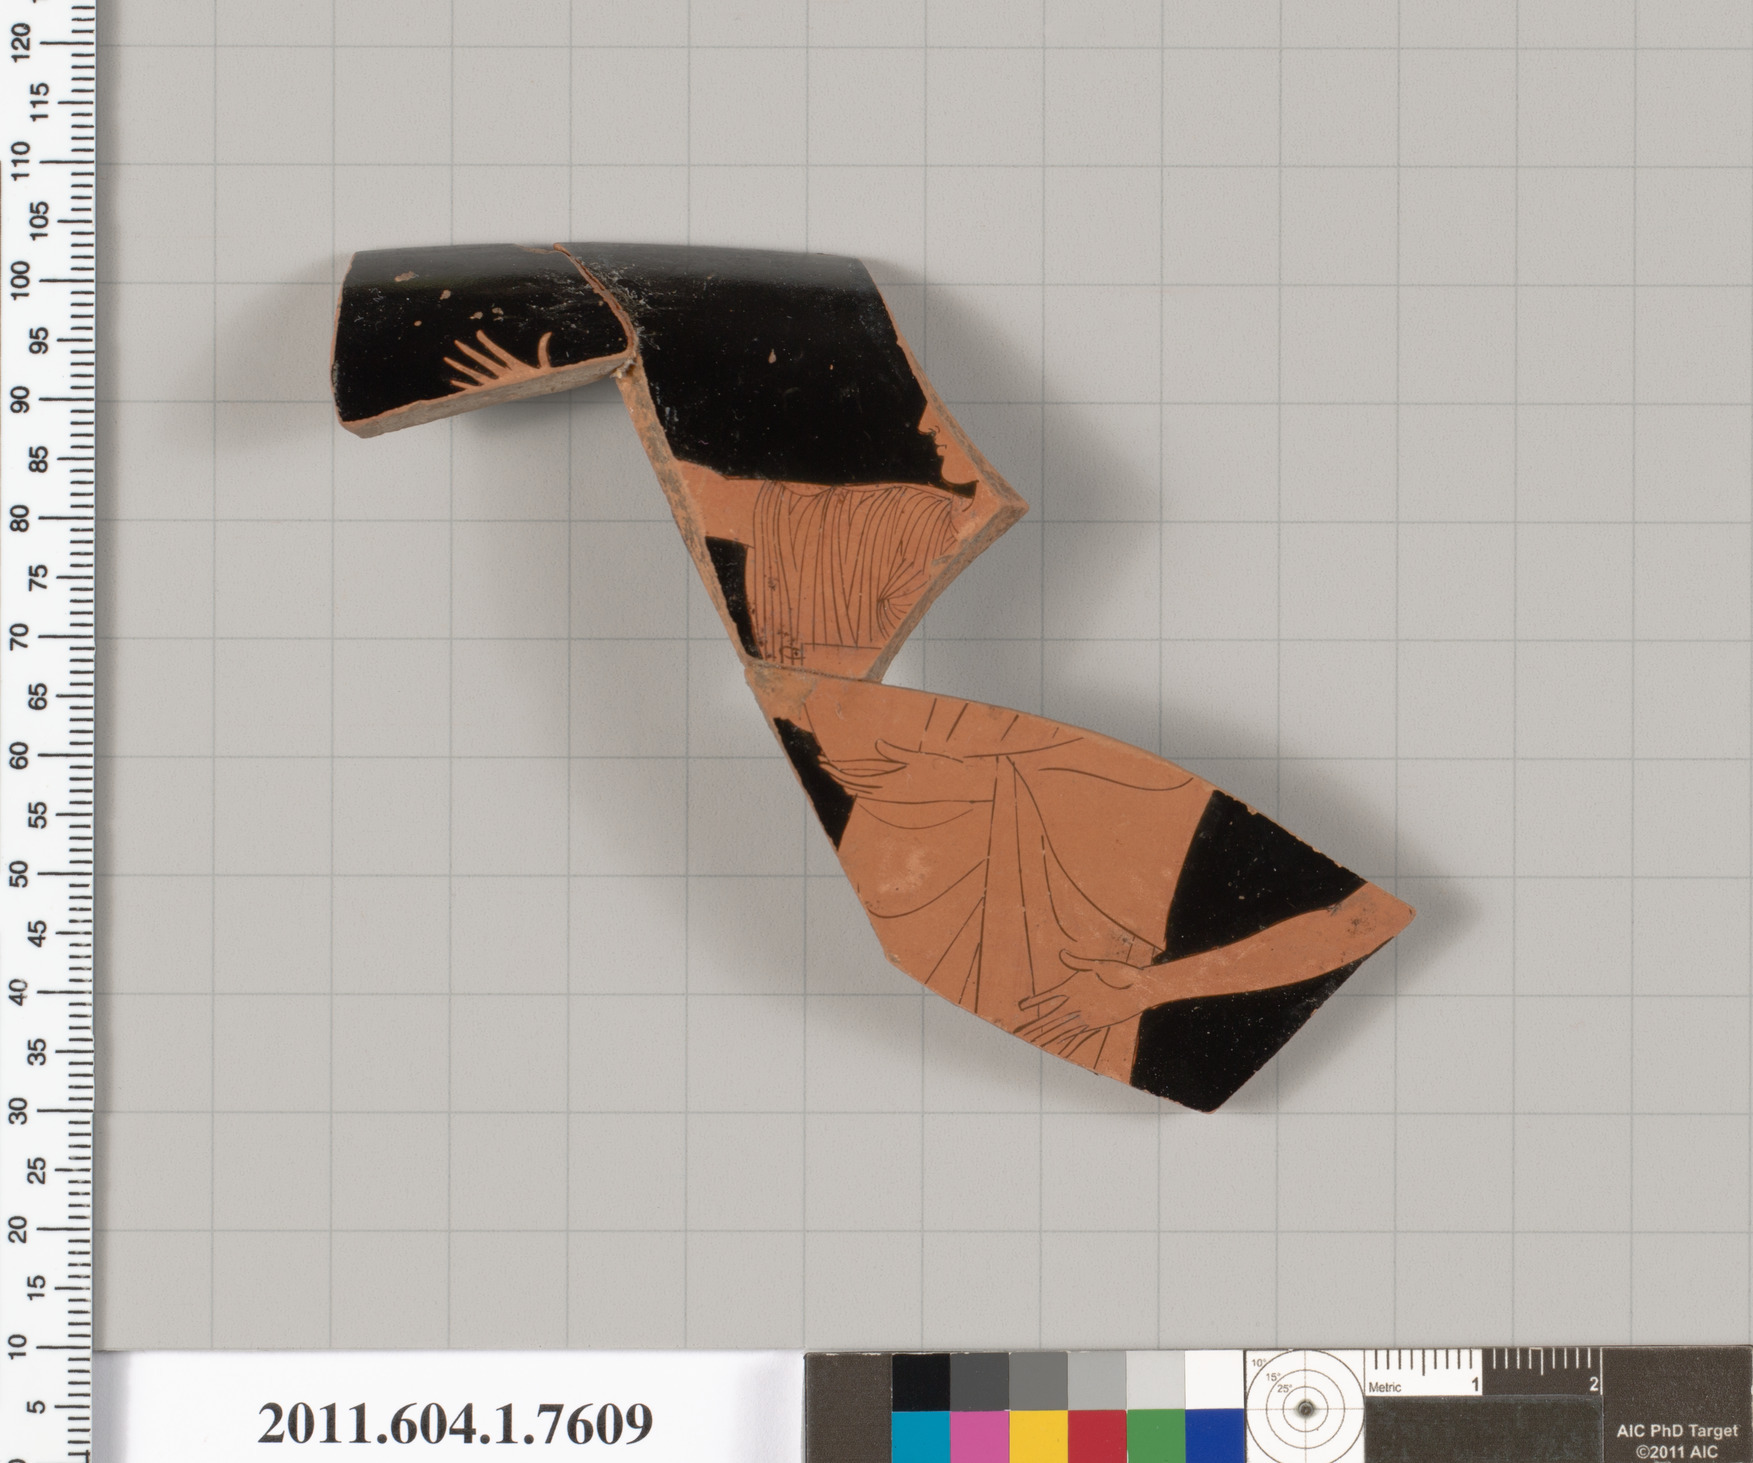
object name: kylix fragment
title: Terracotta rim fragment of a kylix (drinking cup)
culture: greek, attic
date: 460-450 BCE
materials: terracotta